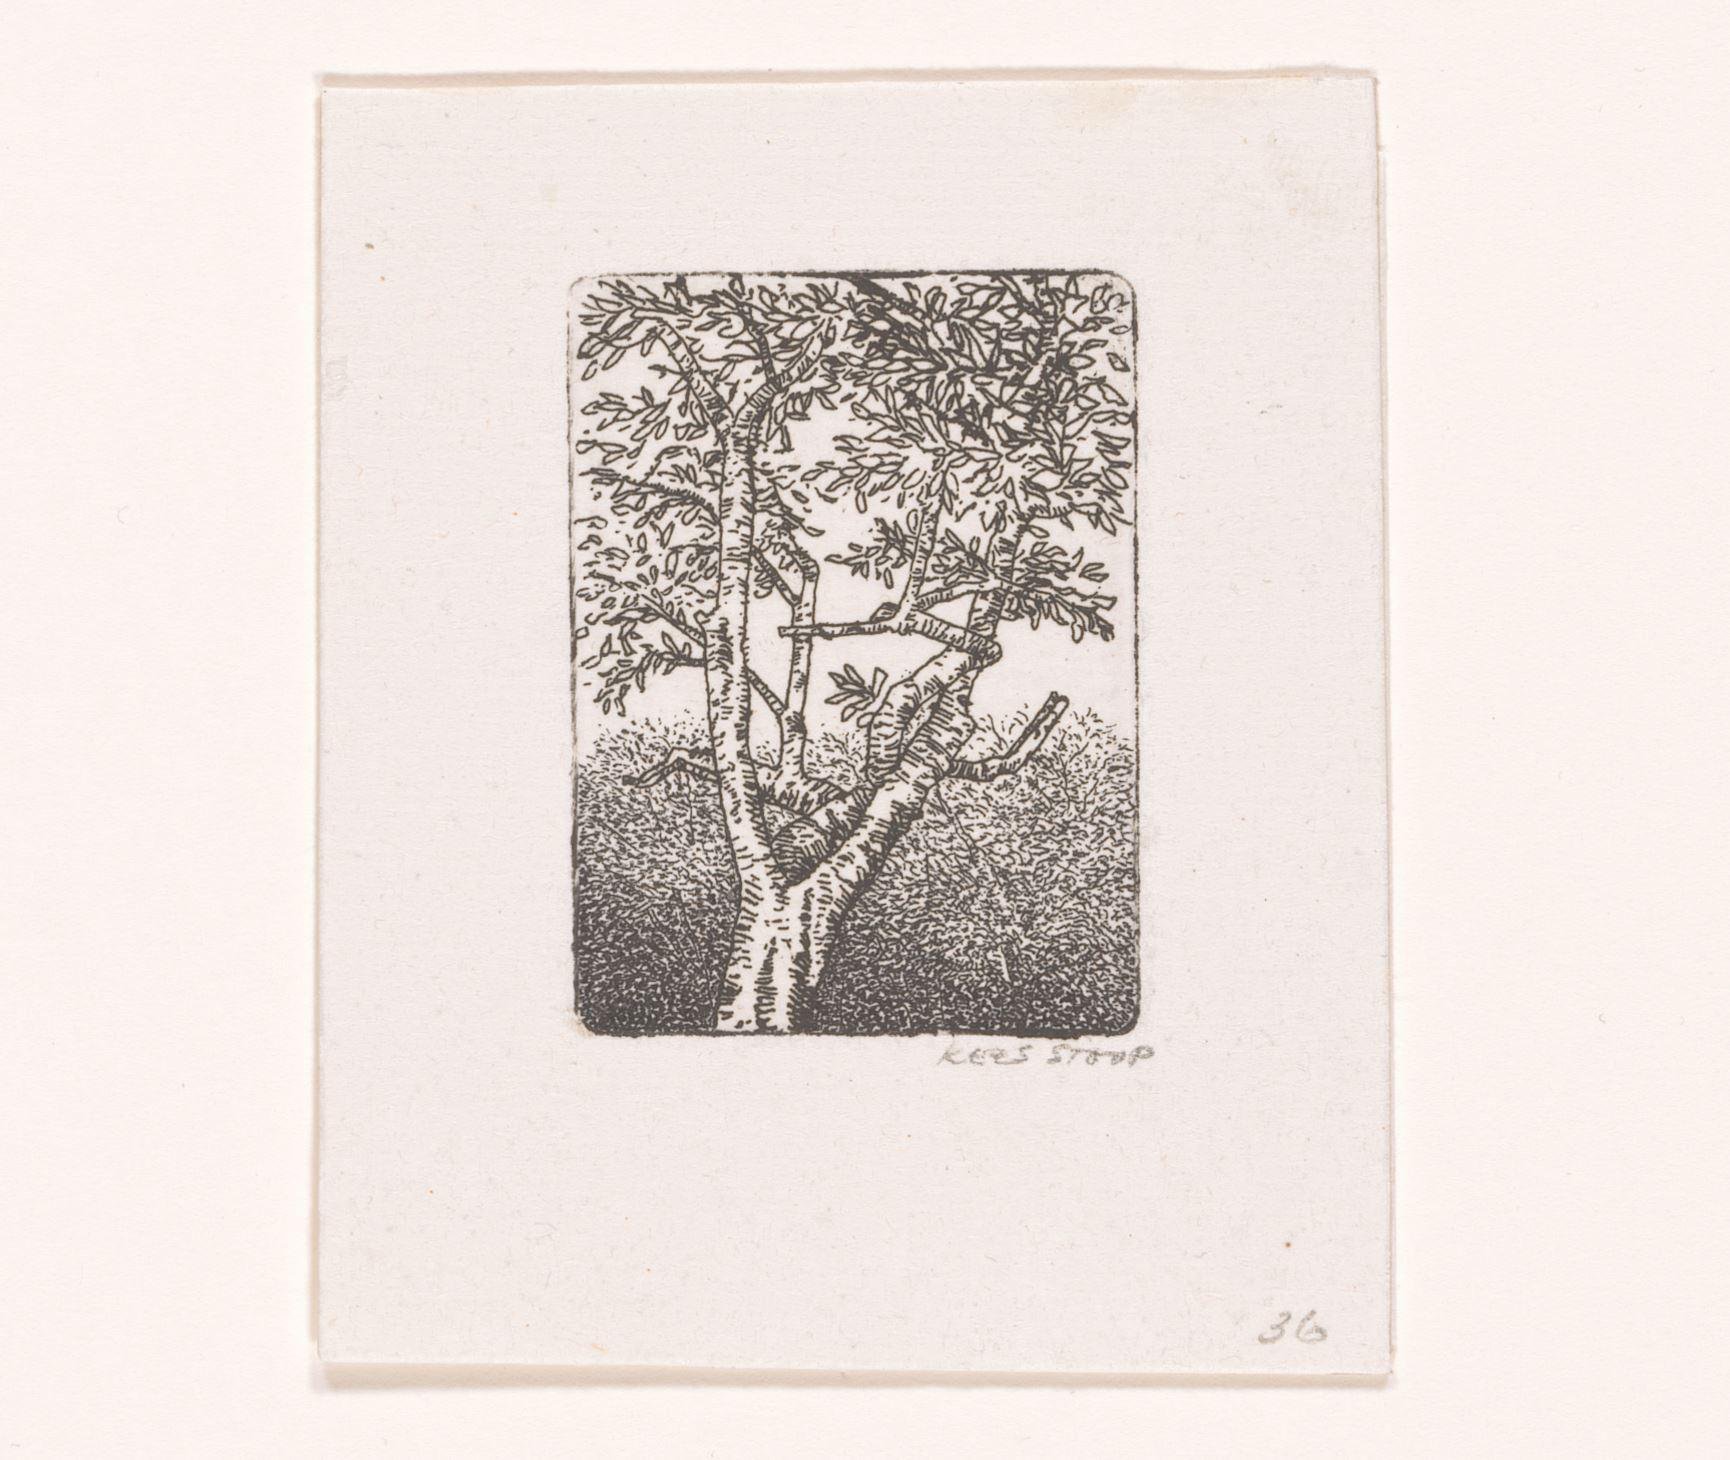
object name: print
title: Boom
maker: kees stoop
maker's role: draughtsman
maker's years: 1929-2019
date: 1977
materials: paper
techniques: etching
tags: trees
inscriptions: signature: ‘KEES STOOP’